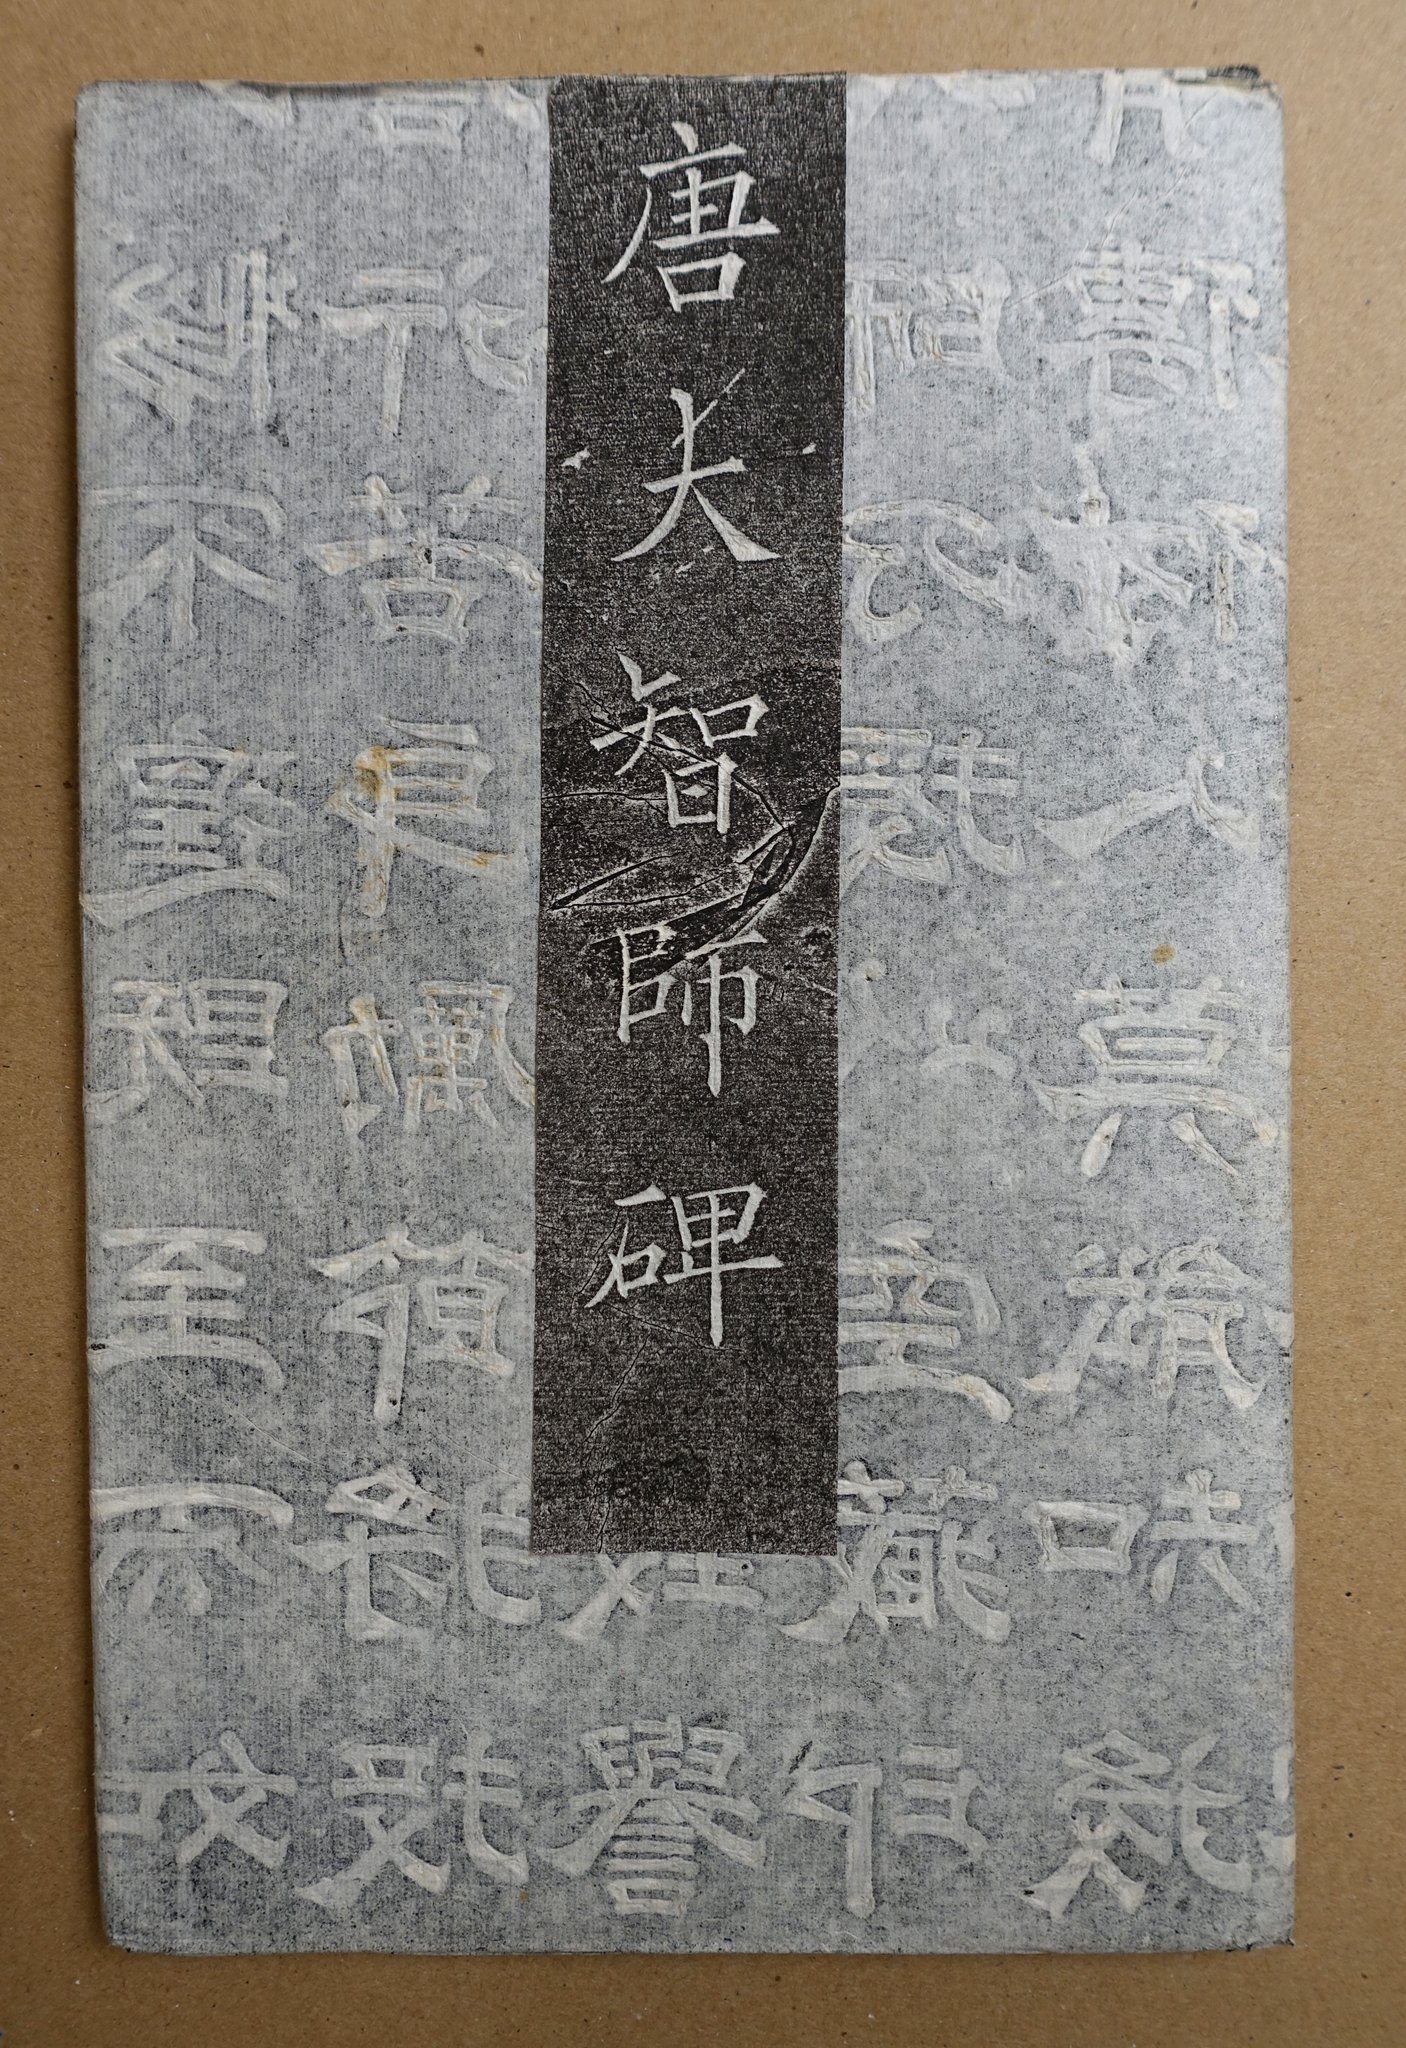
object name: rubbing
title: Epitaph for the Monk Yifu (638-736) known as the Chan Patriarch Dazhi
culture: chinese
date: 1901-2000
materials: ink, paper